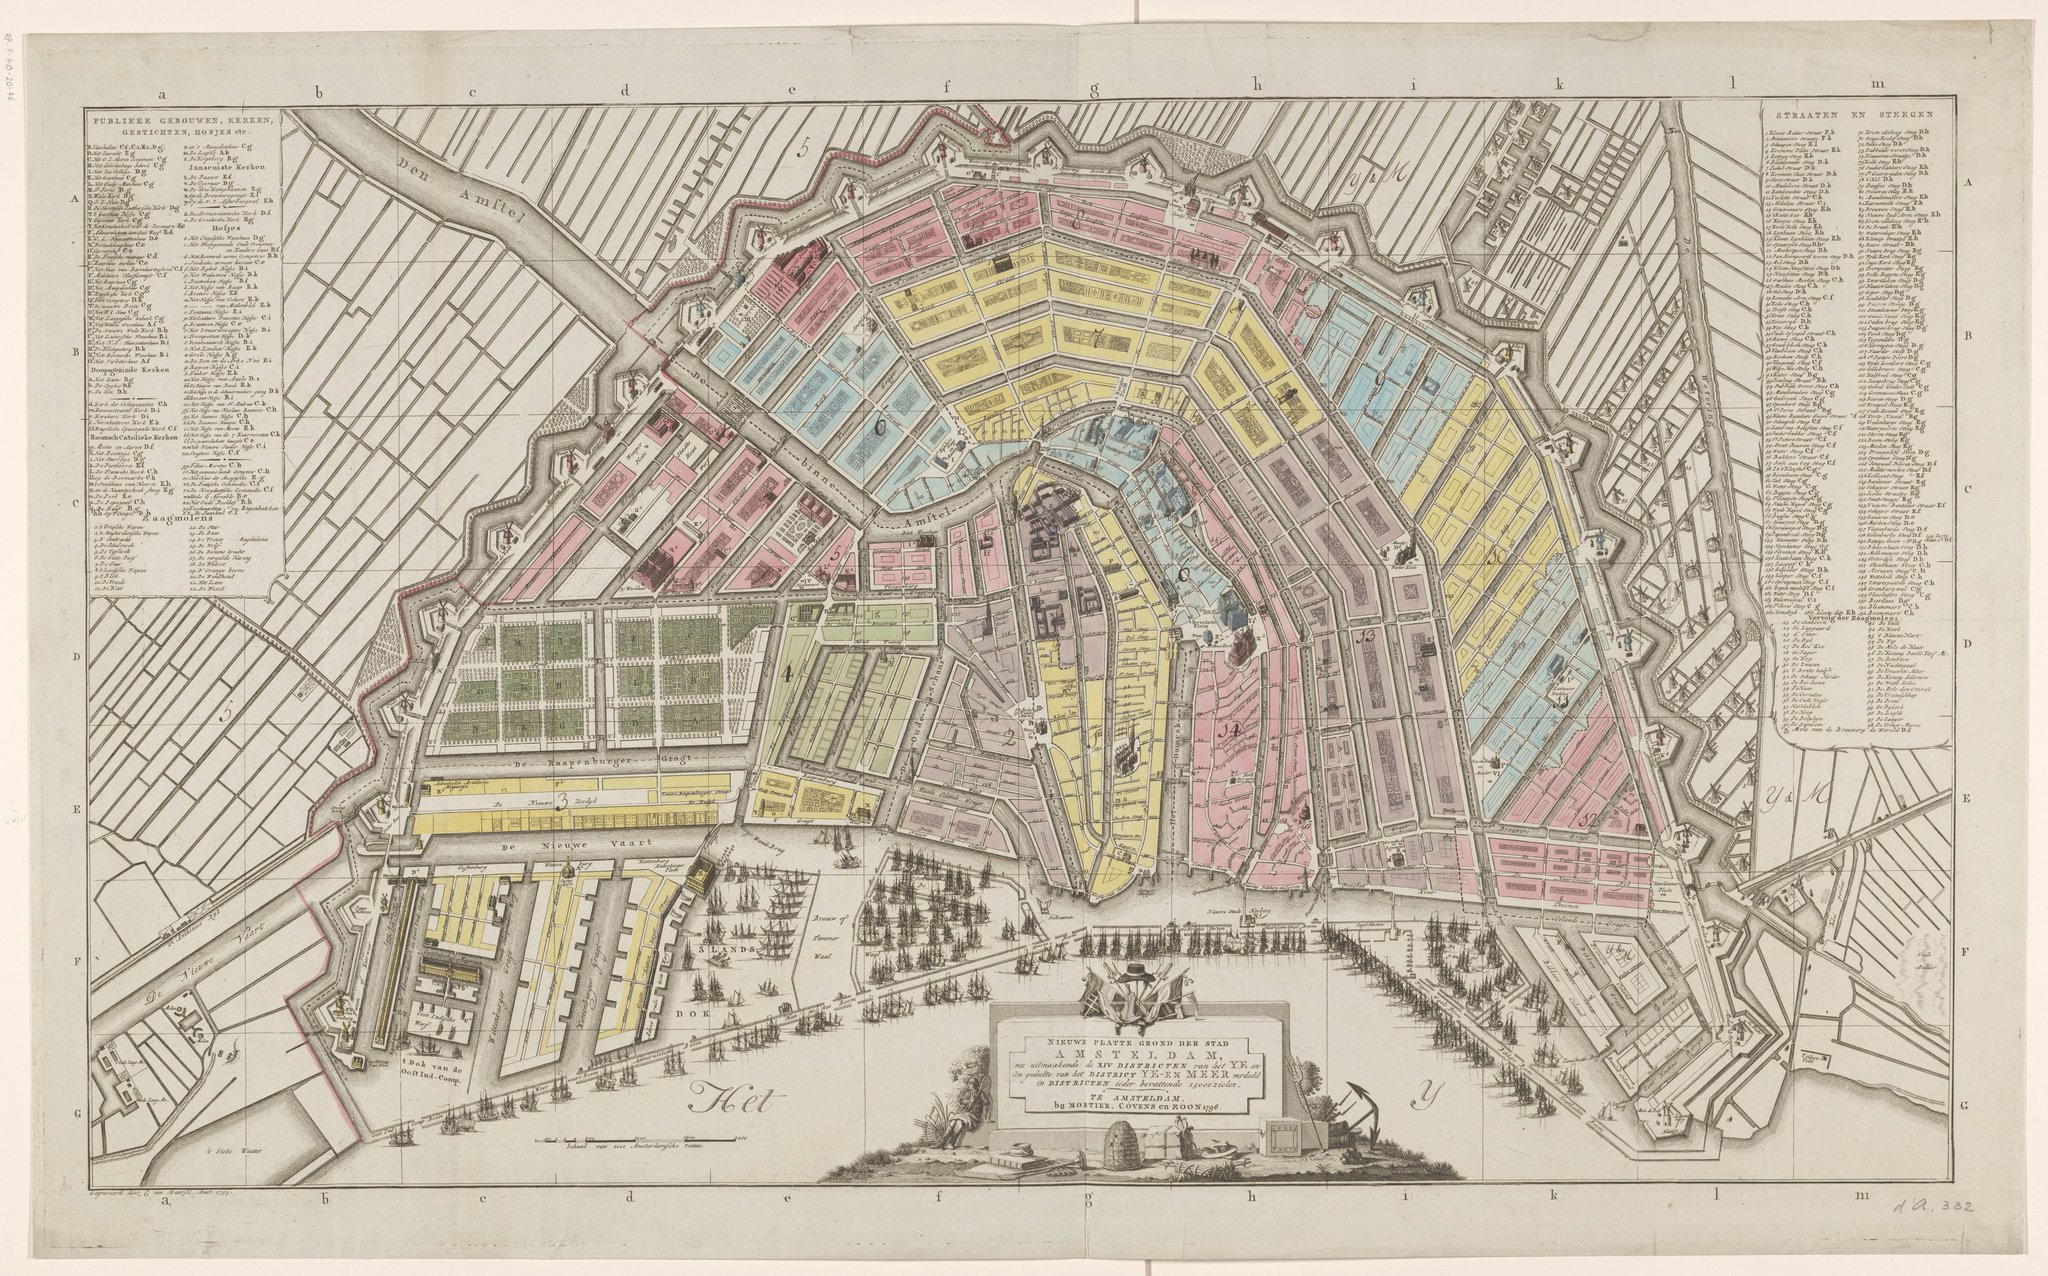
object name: area plan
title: Nieuwe platte grond der stad Amsteldam, nu uitmaakende de XIV districten van het Ye en Een gedeelte van het district Ye-en Meer verdeeld in districten ieder bevattende 15000 zielen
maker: cornelis van baarsel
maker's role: print maker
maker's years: 1761-1826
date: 1795-1796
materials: ink, paper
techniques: brush, engraving, etching, pen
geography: amsterdam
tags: maps of cities, amsterdam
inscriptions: collector's mark: Lugt 2228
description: Plattegrond van Amsterdam tijdens de Bataafse Republiek met indeling in veertien districten. Linksboven de legenda van de gebouwen en het eerste deel van de legenda van de zaagmolens. Rechtsboven de legenda van de straten en stegen en het vervolg van de legenda van de zaagmolens. Onder in het midden de titelcartouche. Links daarvan de schaalstok: Schaal van 2000 Amsterdamsche Voeten. Met zoekrooster. Oriëntatie: zuidzuidwest boven.